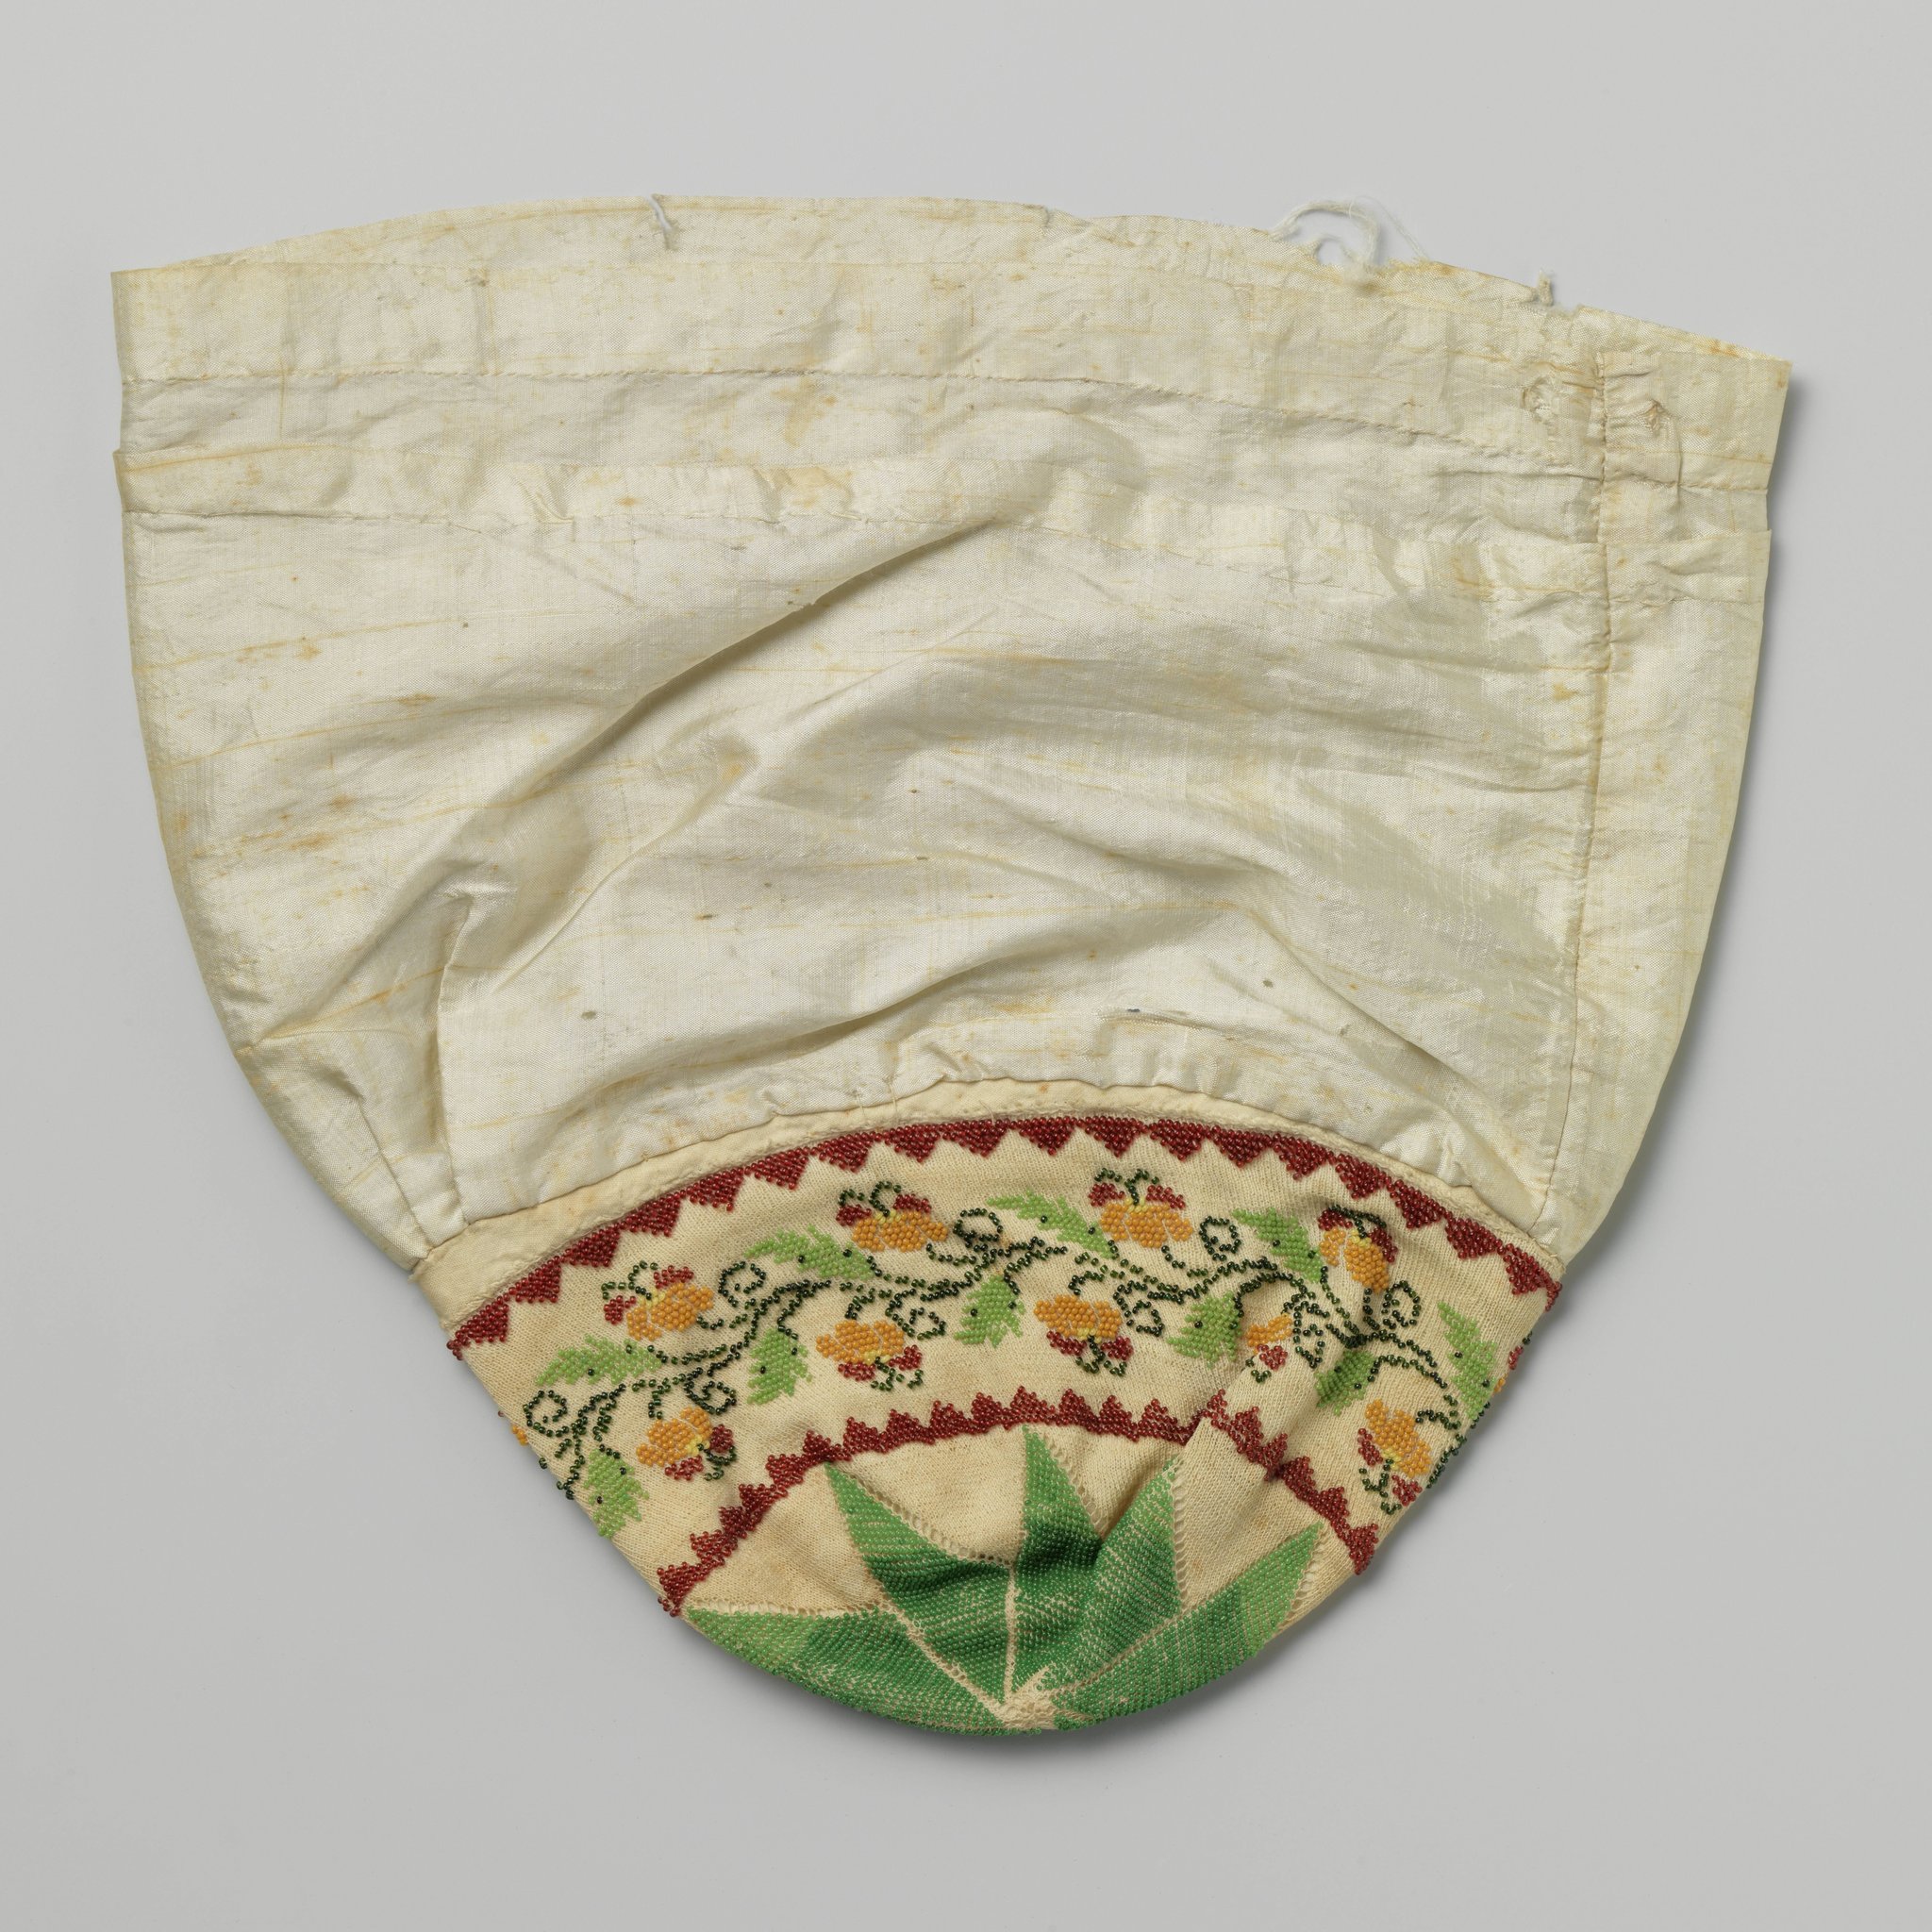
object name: tobacco pouch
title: Buidel in halfronde vorm, van ivoorkleurige zijde aan gebreide katoenen bodem met ingebreide ster en bloemenrand van kralen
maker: Anonymous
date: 1820-1850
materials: cotton, glass, silk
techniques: glassblowing, knitting, weave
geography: netherlands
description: Buidel in halfronde vorm, van ivoorkleurige zijde aan gebreide katoenen bodem, met ingebreide groene achtpuntige ster. Rondom de ster een dubbele rand met rode kralen in aangesloten piramidevorm, waarbinnen een baan van kralen in de vorm van gele en rode bloemen en groene bladeren. De tas heeft geen voering of sluiting.